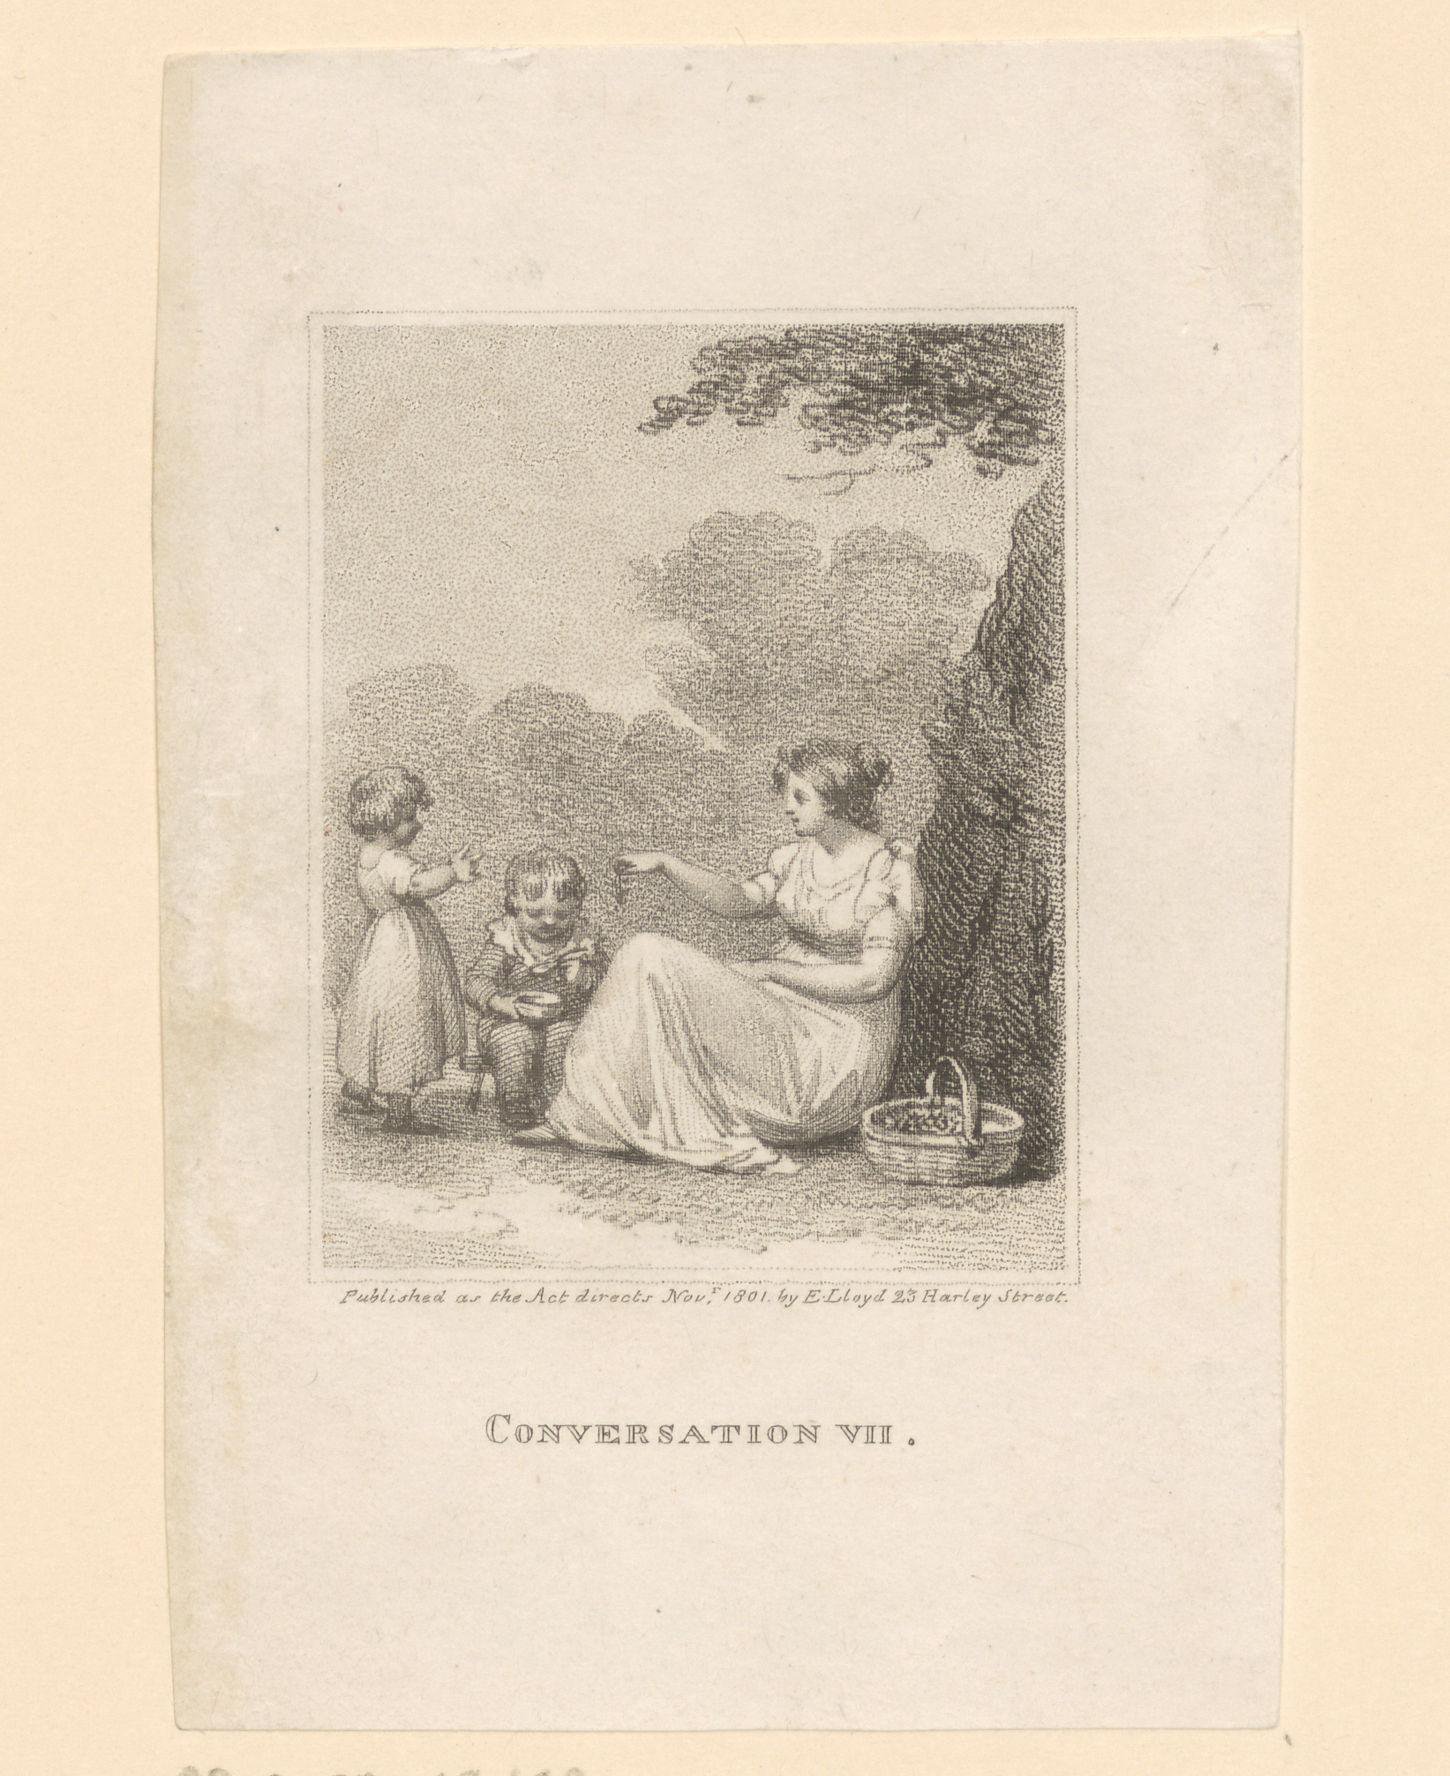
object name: print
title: Conversation VII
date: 1801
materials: paper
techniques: etching, soft ground etching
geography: london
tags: giving food, picnic, alfresco, 'déjeuner sur l'herbe', sitting on the ground - aa - female human figure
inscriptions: collector's mark: Lugt 2228